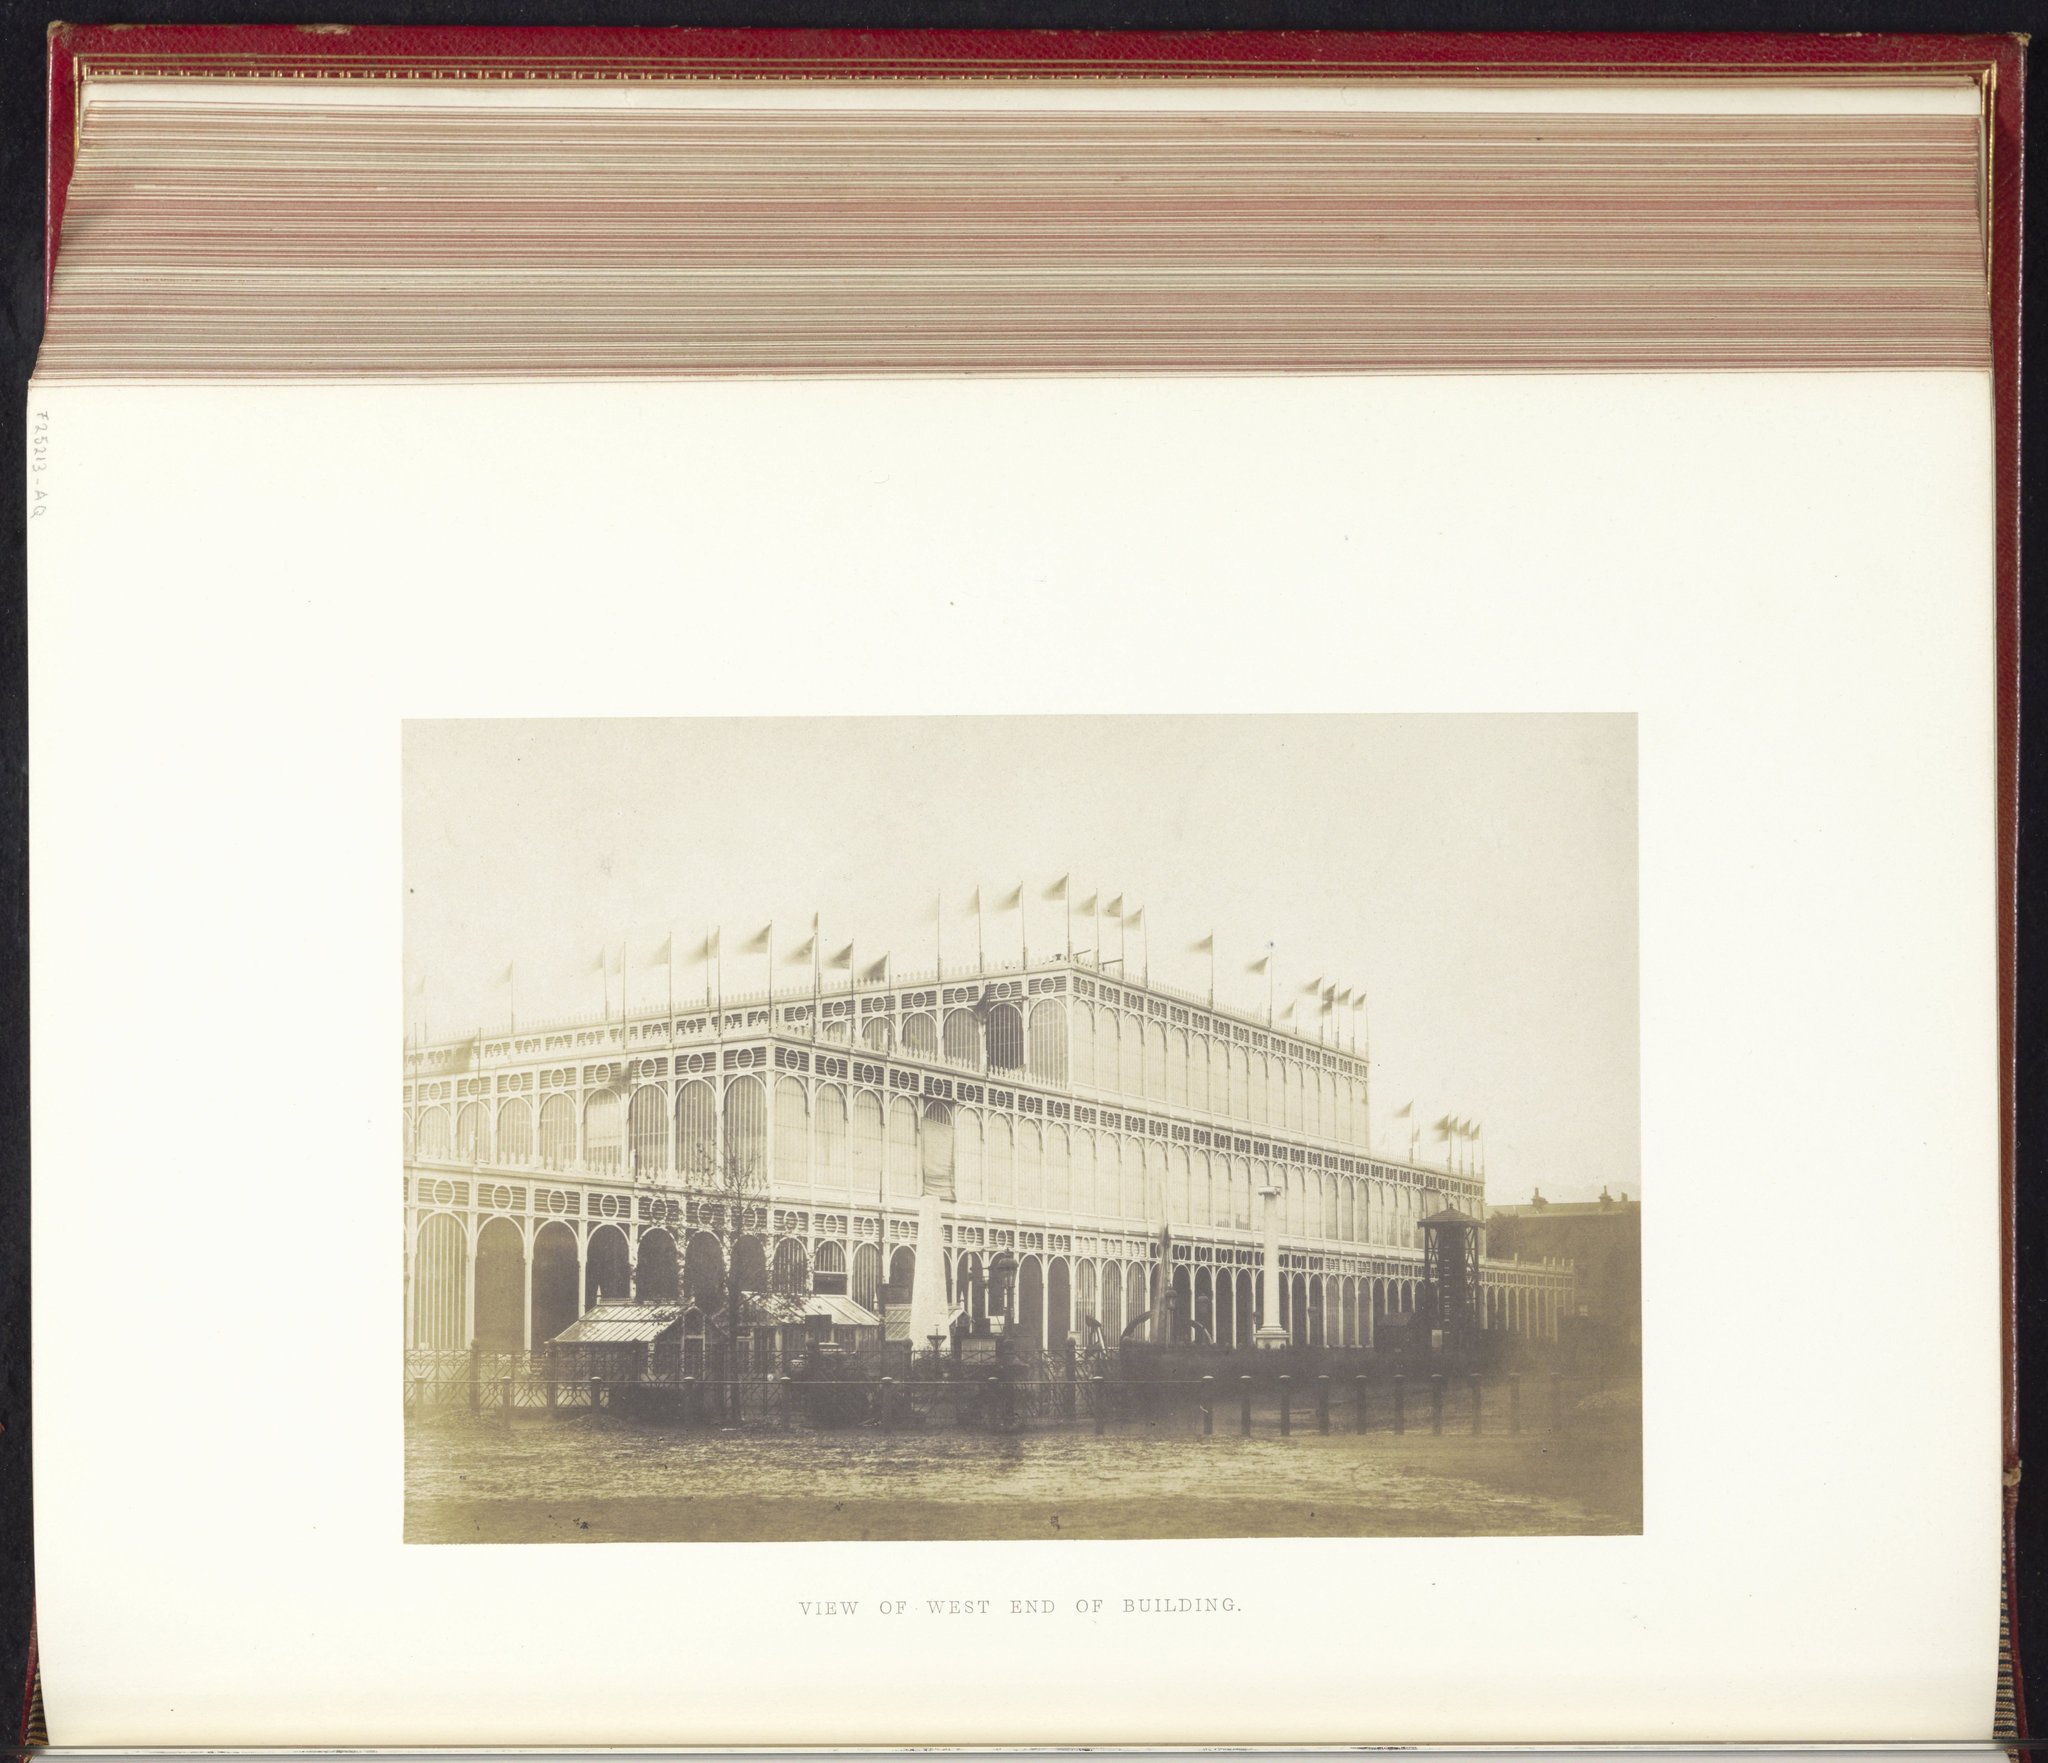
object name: page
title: Gezicht op het Crystal Palace in Londen tijdens de Great Exhibition of the Works of Industry of All Nations van 1851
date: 1851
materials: photographic support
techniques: salted paper print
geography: london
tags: world fair, world exhibition